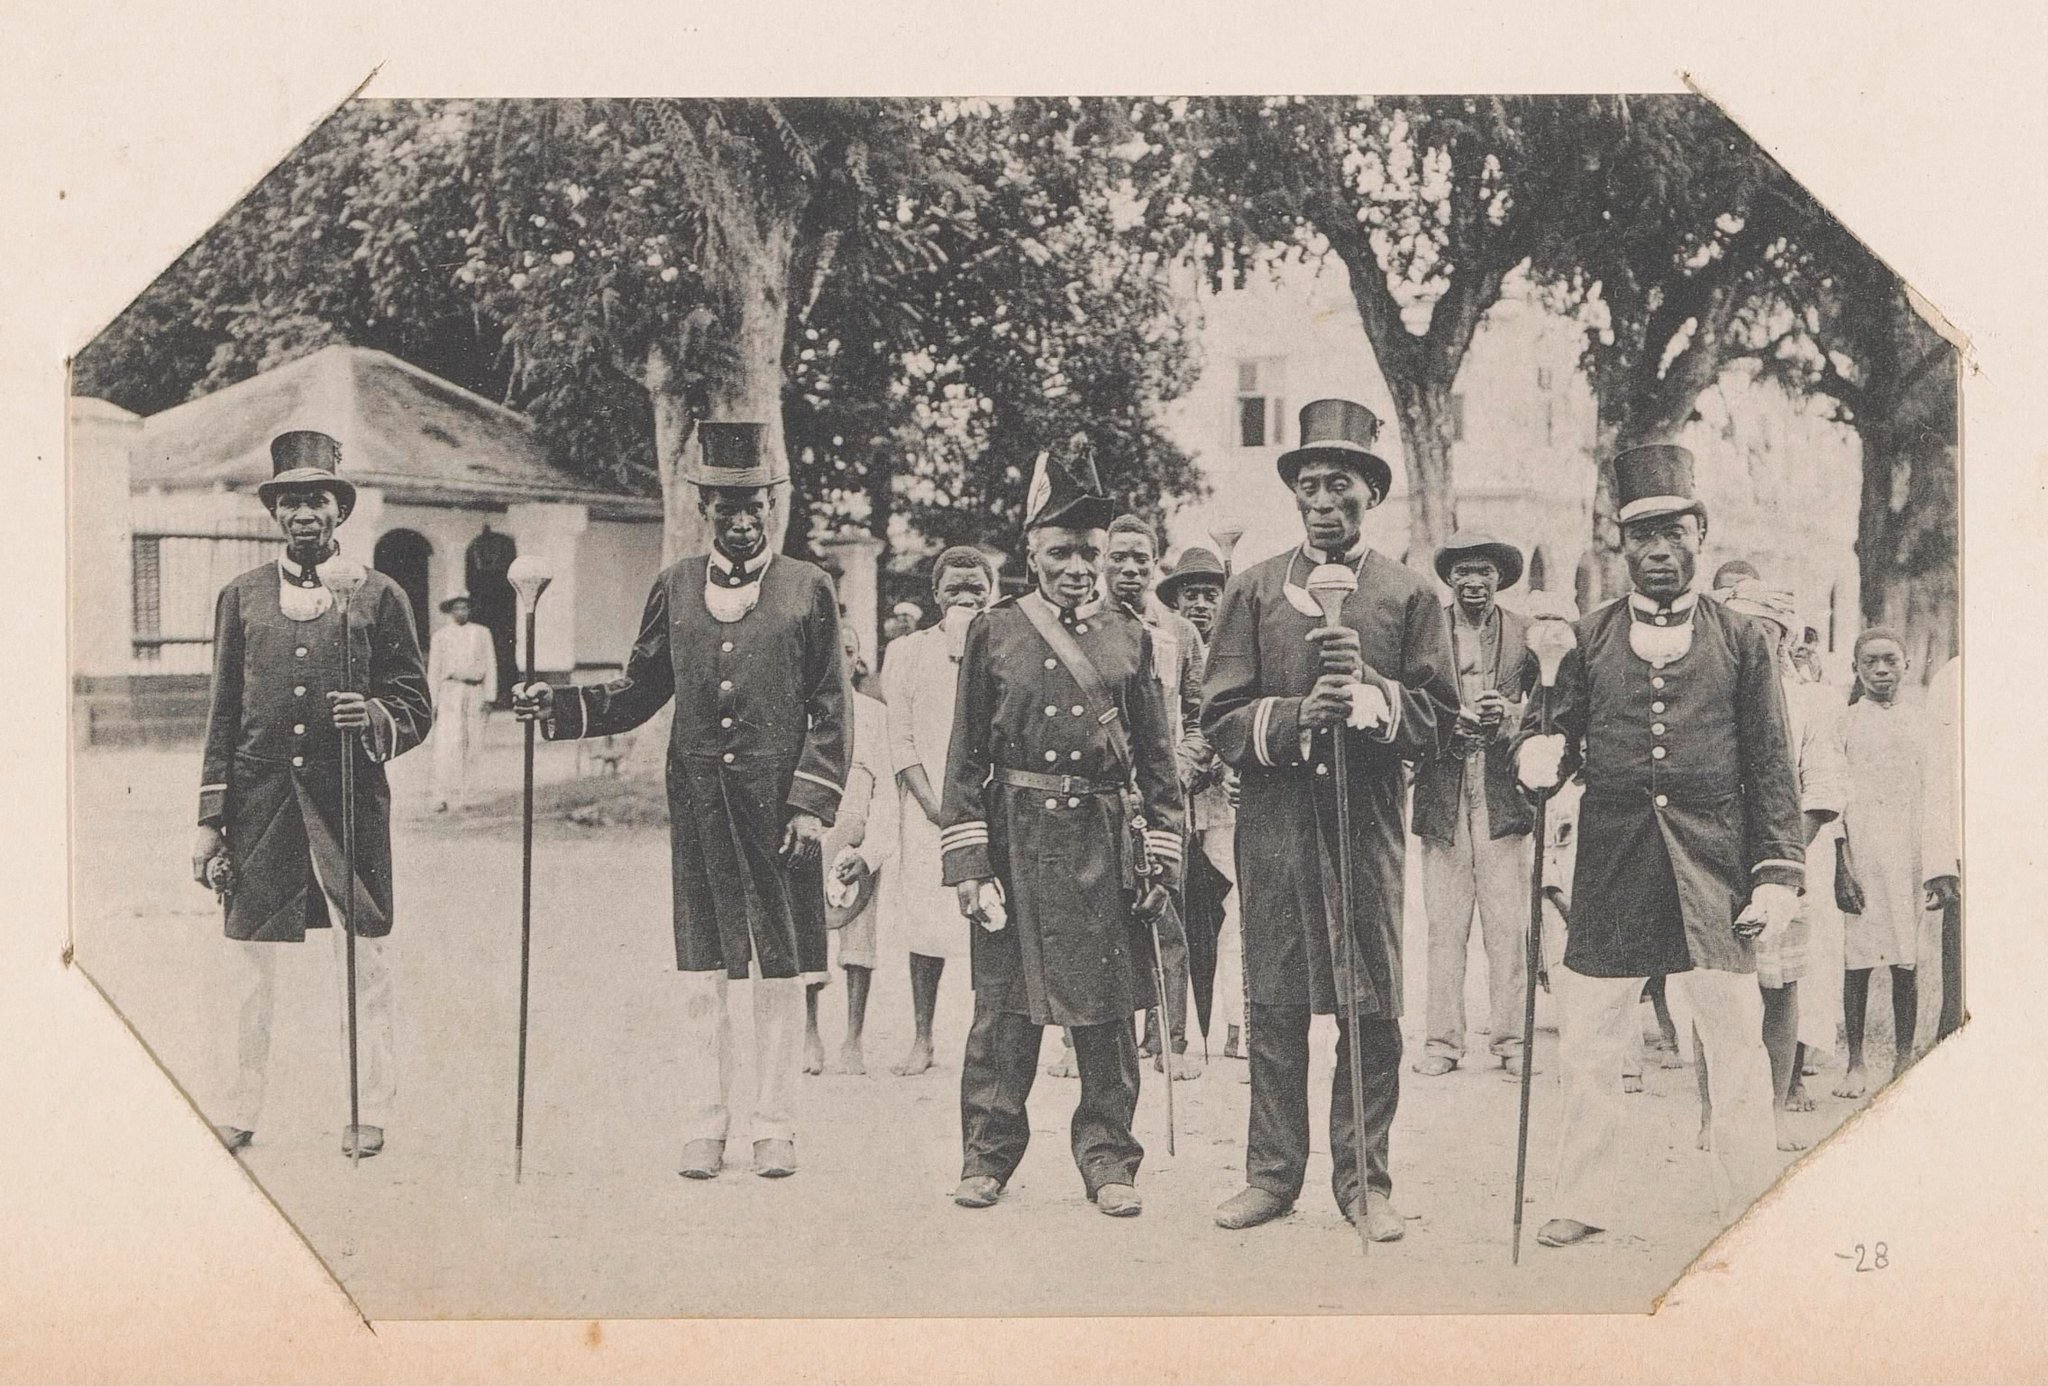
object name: ansichtkaart, prentbriefkaart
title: Granman en andere gezagsdragers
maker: eugen klein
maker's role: fotograaf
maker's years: 1869-1927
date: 1900-1910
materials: cardboard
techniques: photograph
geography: suriname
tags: ranks ~ rulers, sovereigns, suriname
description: Groepsfoto van een granman vergezeld door vier andere gezagsdragers (kapiteins). Onderdeel van een verzameling van 68 briefkaarten uit Suriname, bijeengebracht in een album als aandenken aan een verblijf in Suriname in september 1911.